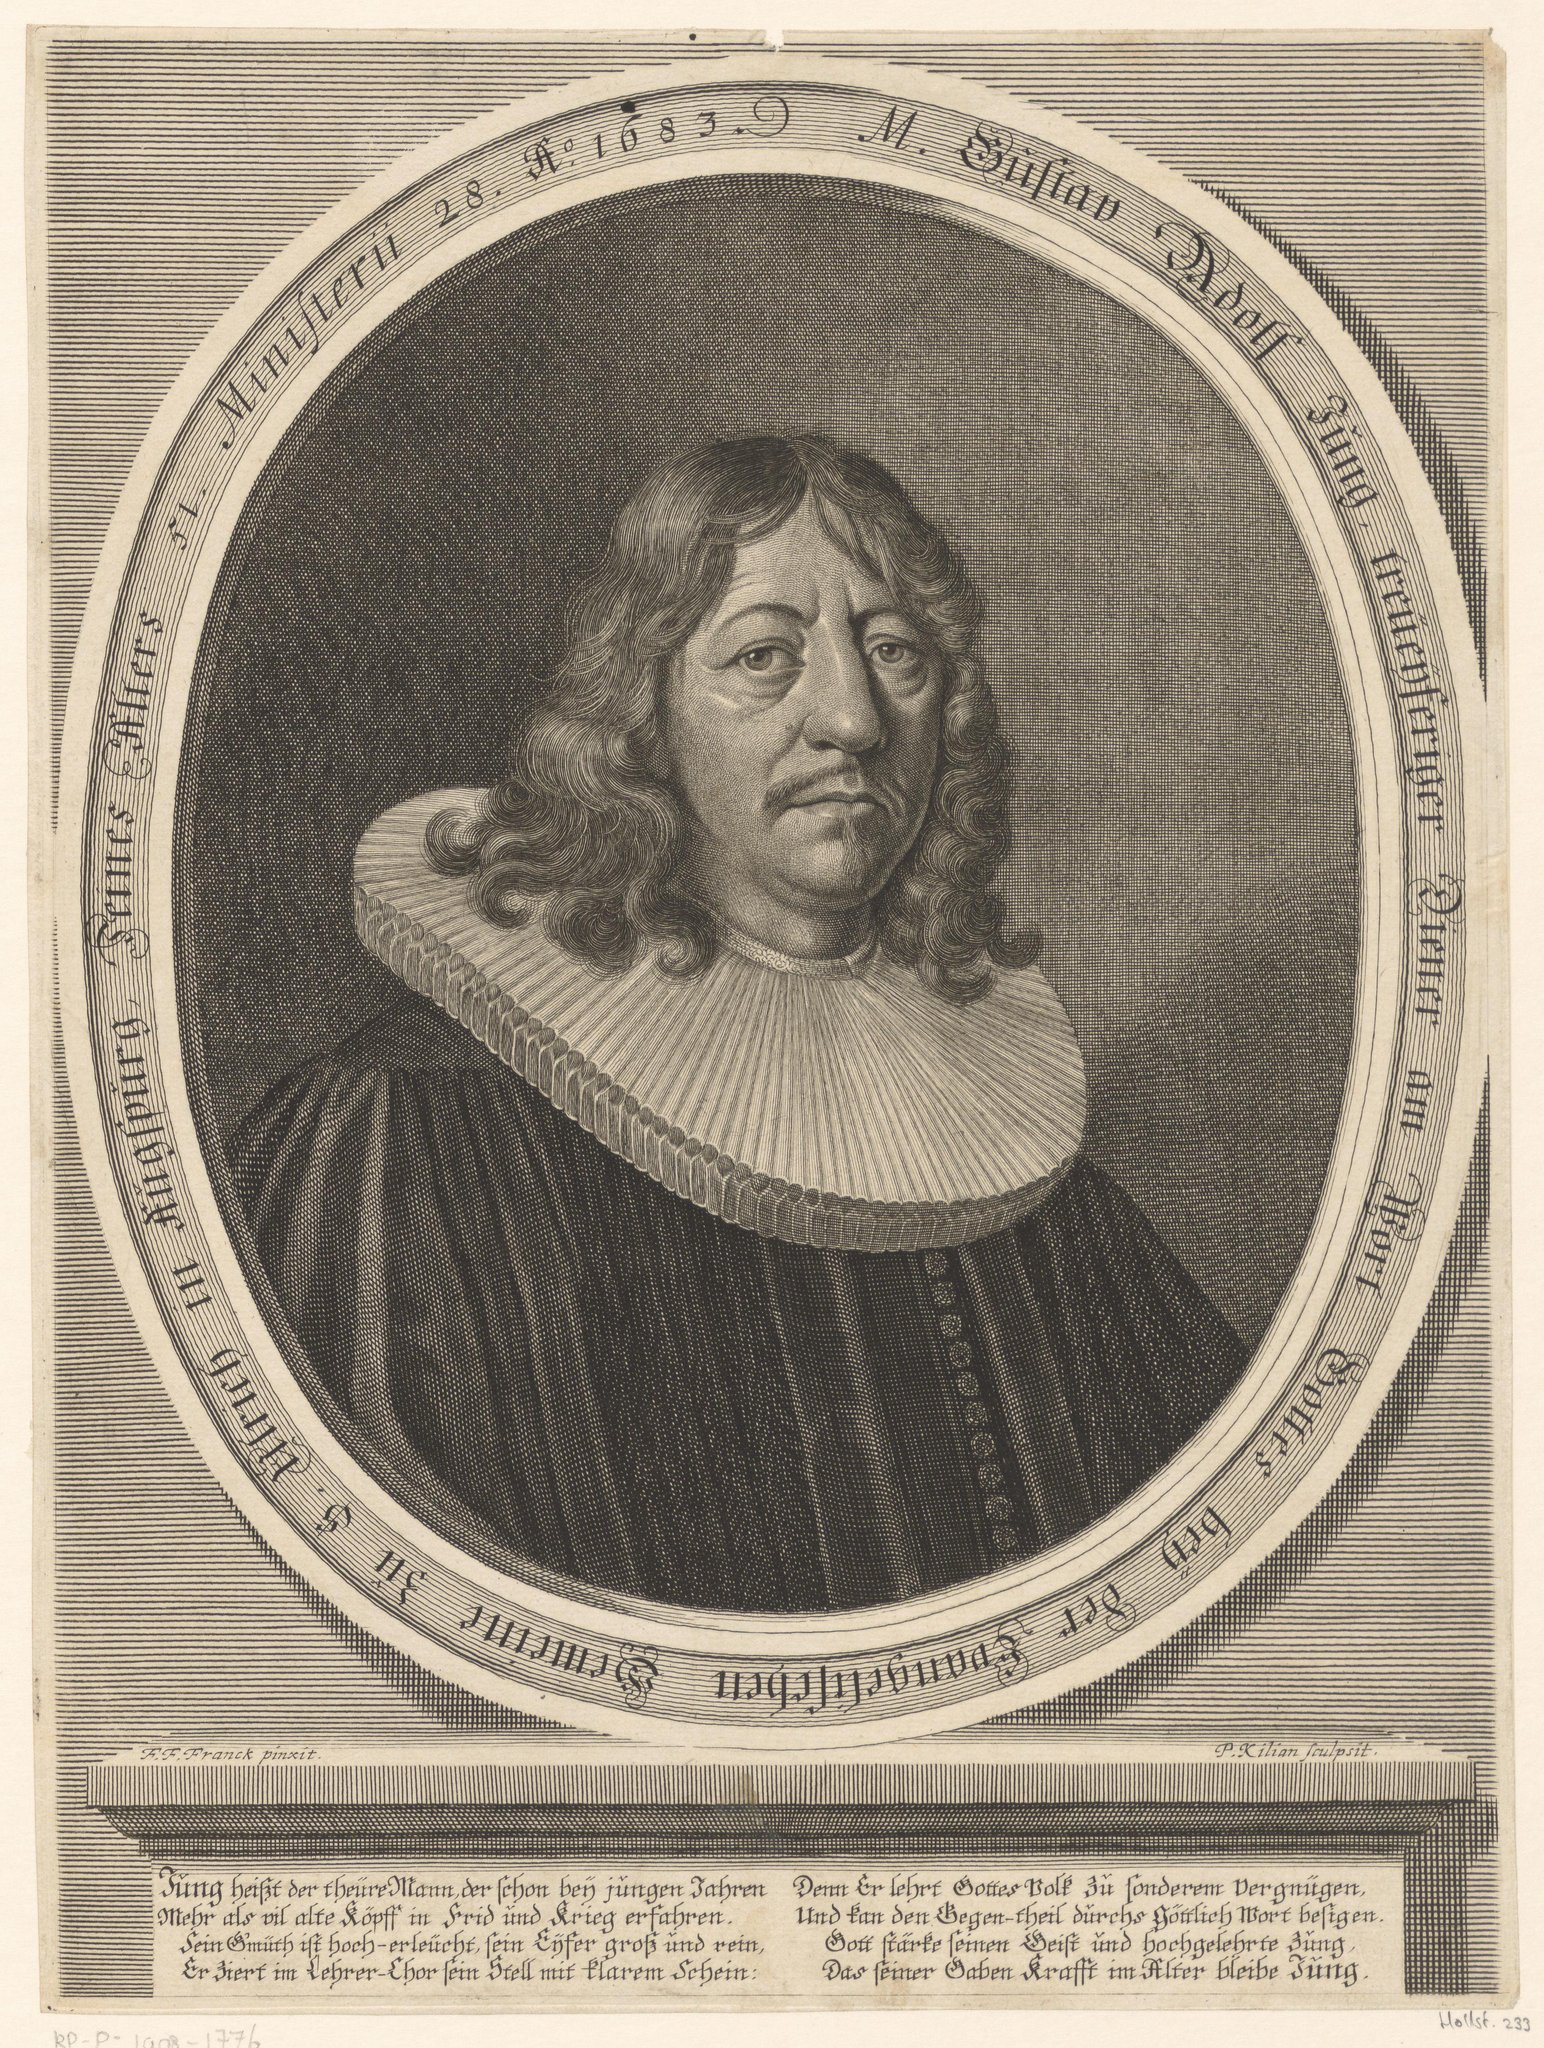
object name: print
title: Portret van Gustav Adolf Jung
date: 1683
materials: paper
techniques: engraving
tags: augsburg, theologian, historical persons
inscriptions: collector's mark: Lugt 2228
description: Tekst in het Latijn in de omlijsting en op de sokkel.